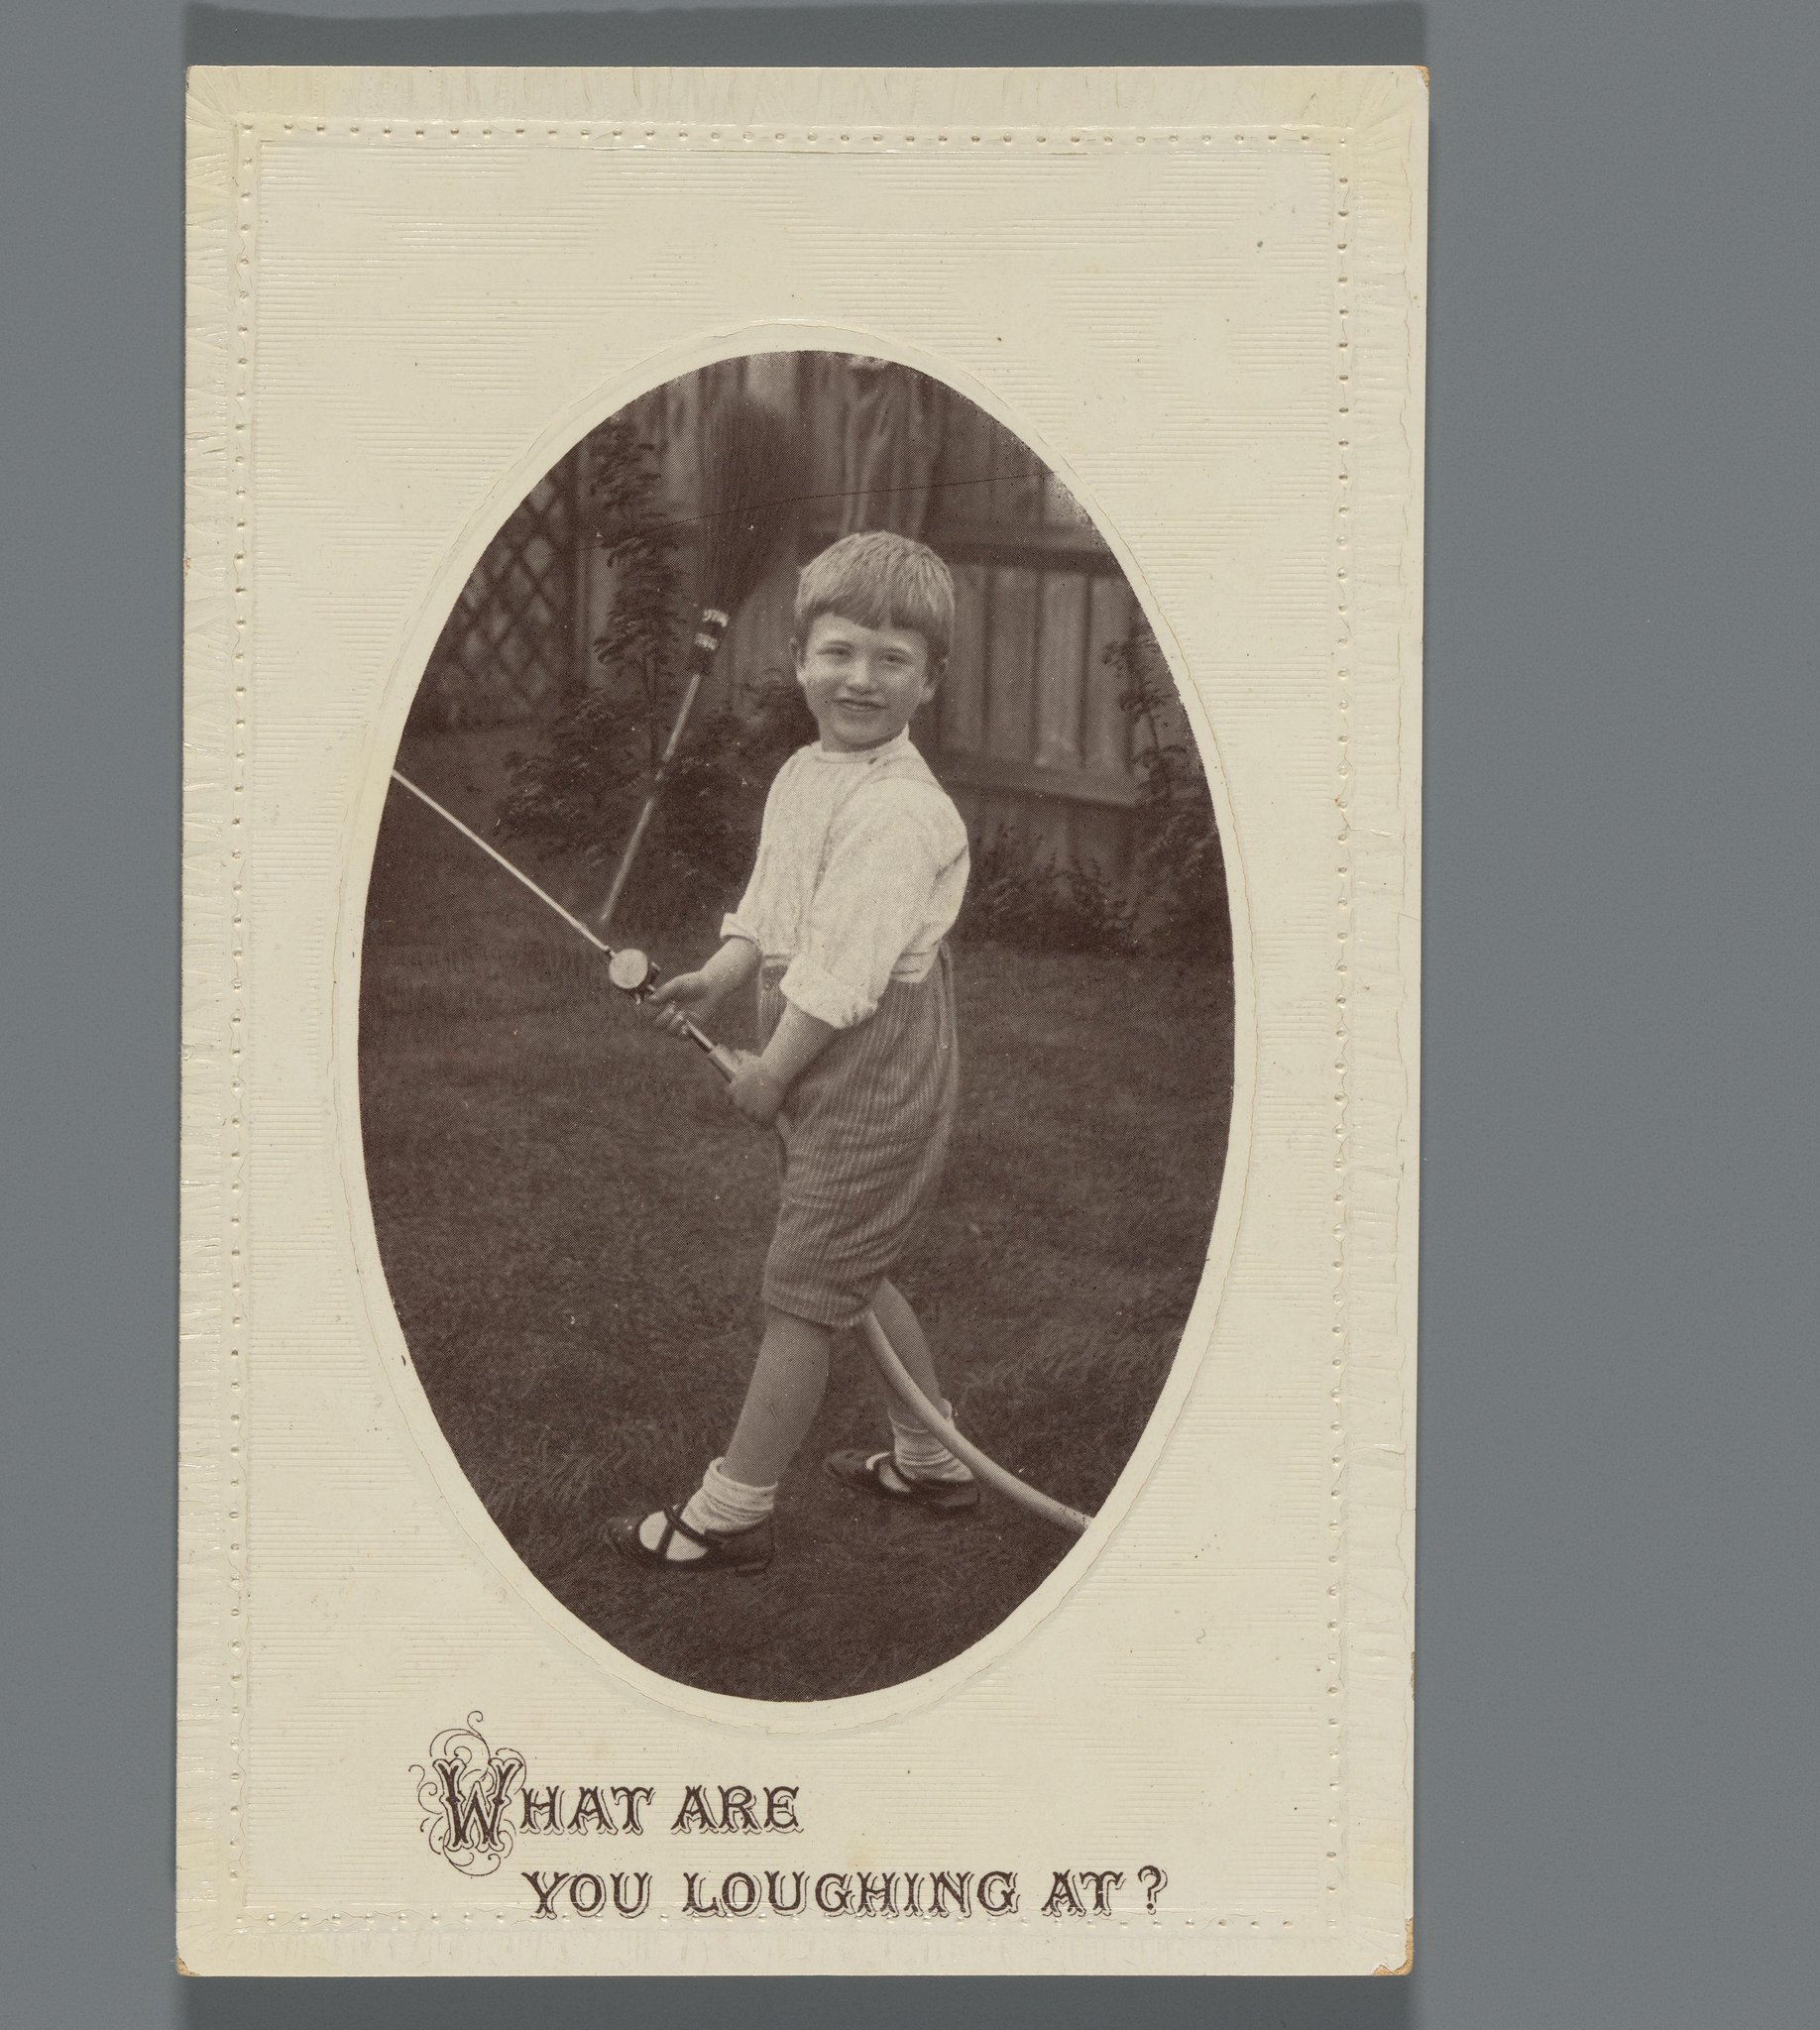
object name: photomechanical print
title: What are you loughing at?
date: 1906-1909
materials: paper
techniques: autotype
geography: london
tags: boy (child between toddler and youth)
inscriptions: inscription: ‘No. 52. Printed in Saxony.’